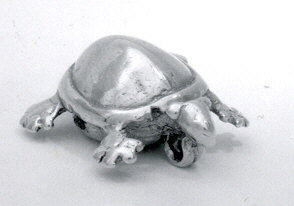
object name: bell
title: Turtle Bell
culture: central caribbean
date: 900-1520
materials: gold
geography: costa rica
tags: musical instruments,turtles